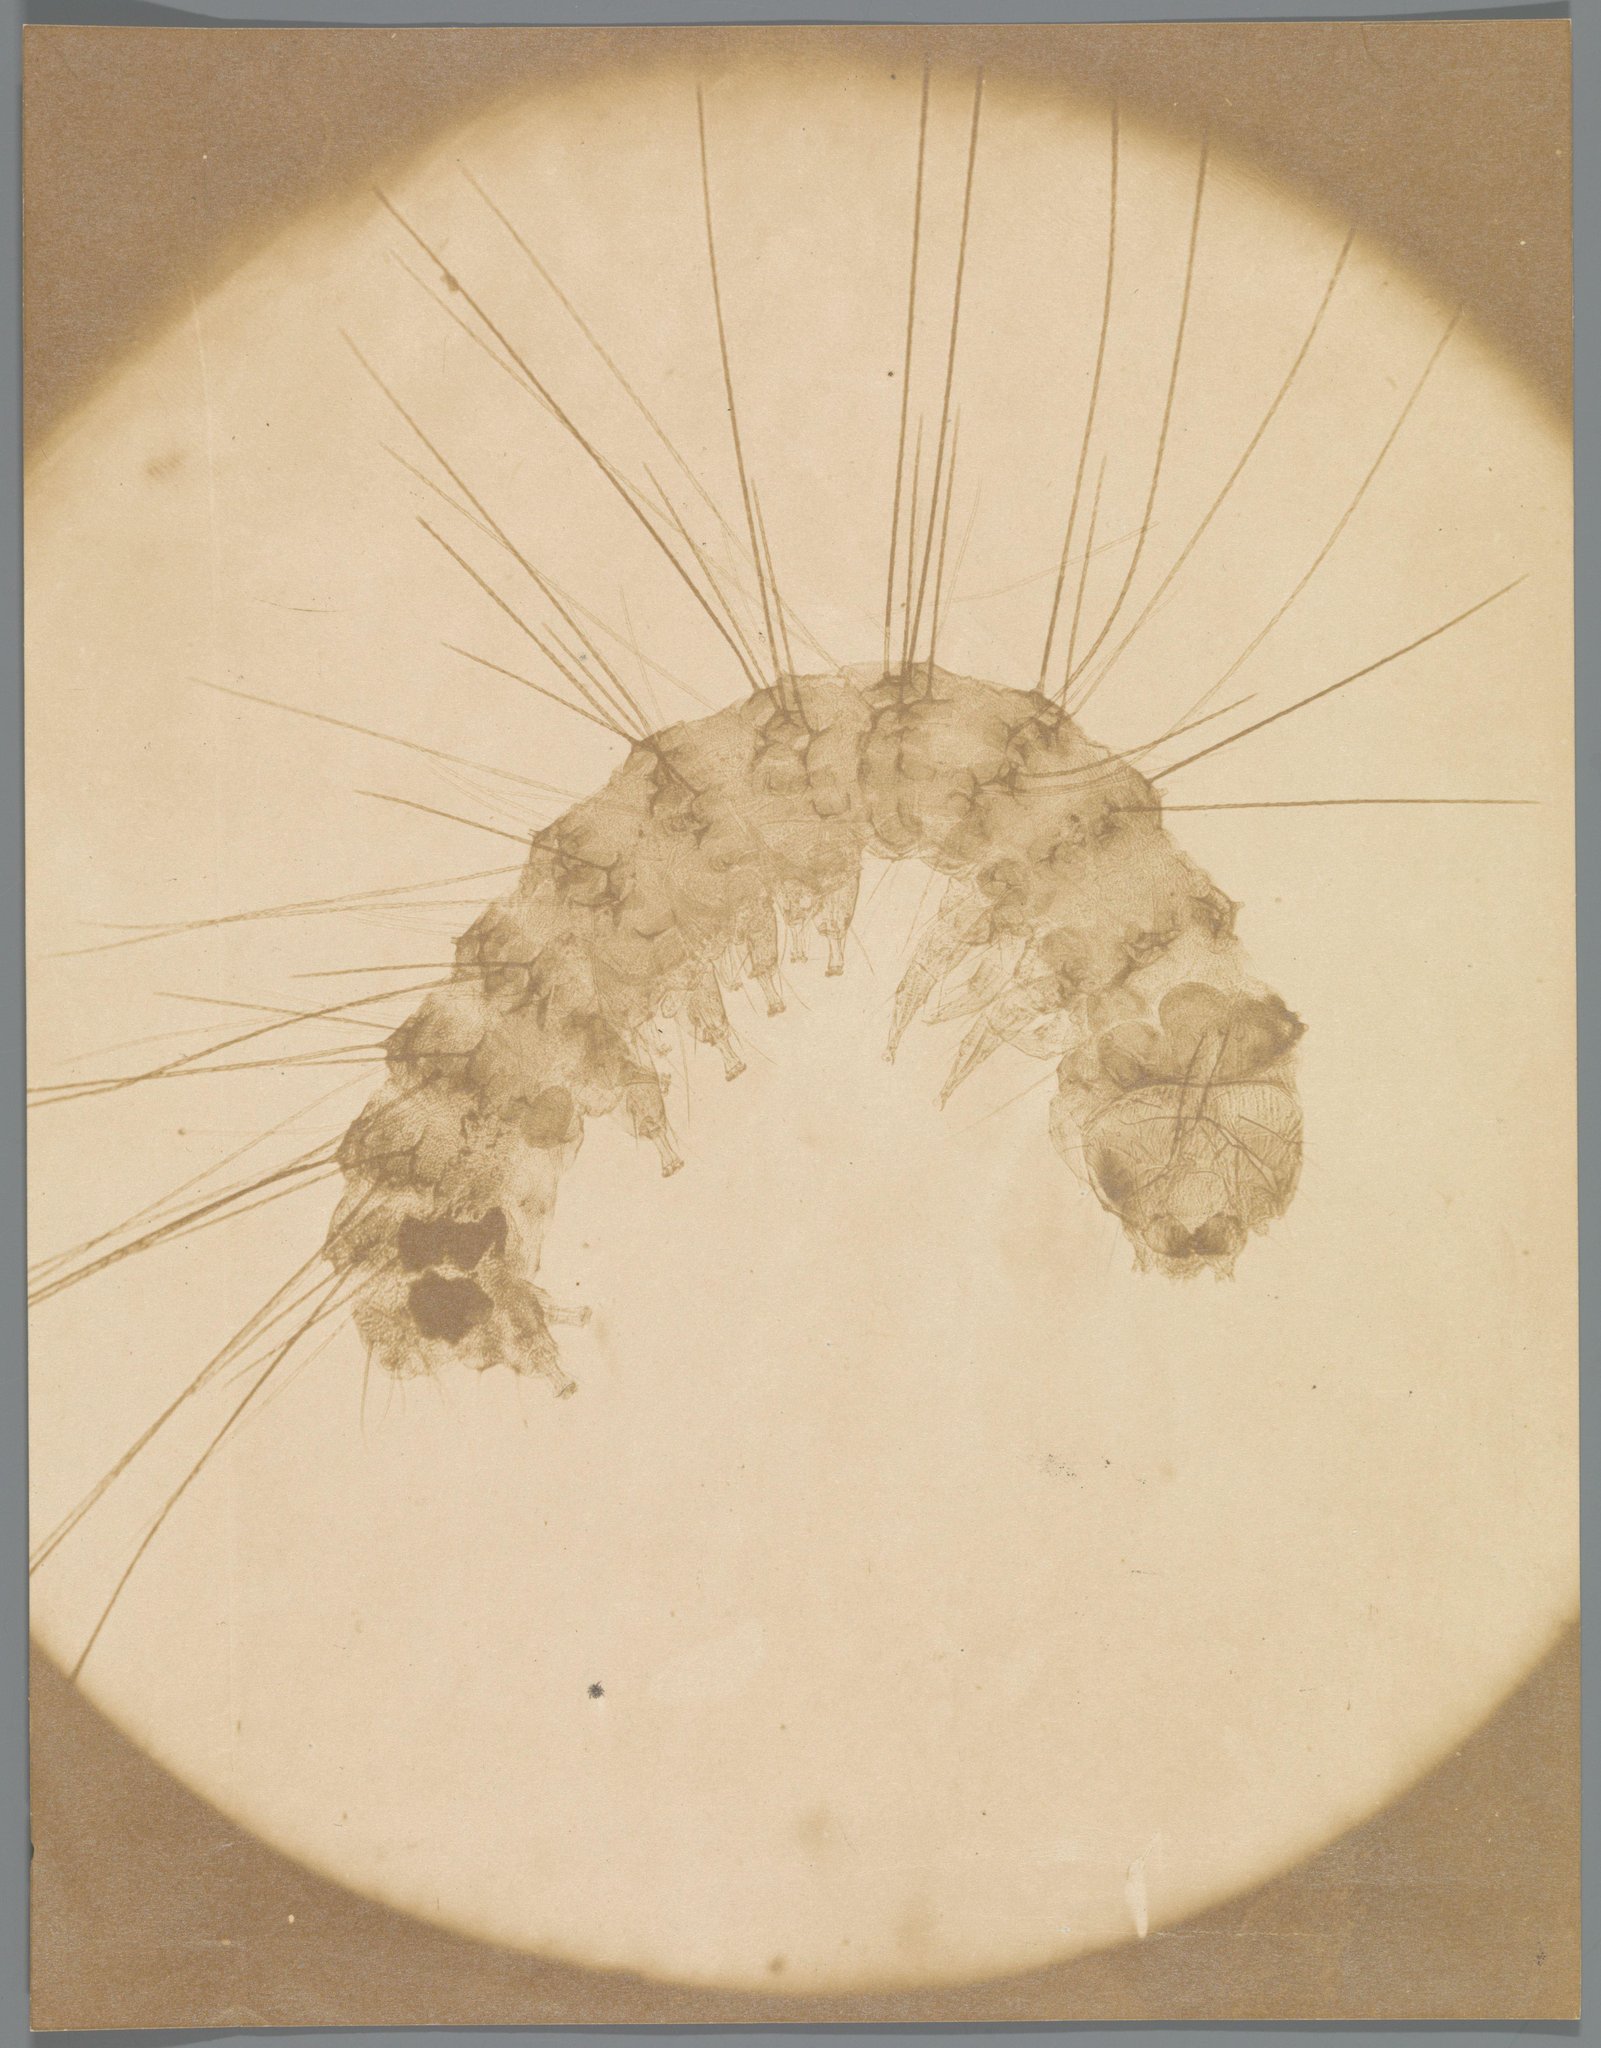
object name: micro opname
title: Microscopische opname van een insect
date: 1853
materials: paper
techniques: salted paper print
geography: austria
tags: insects